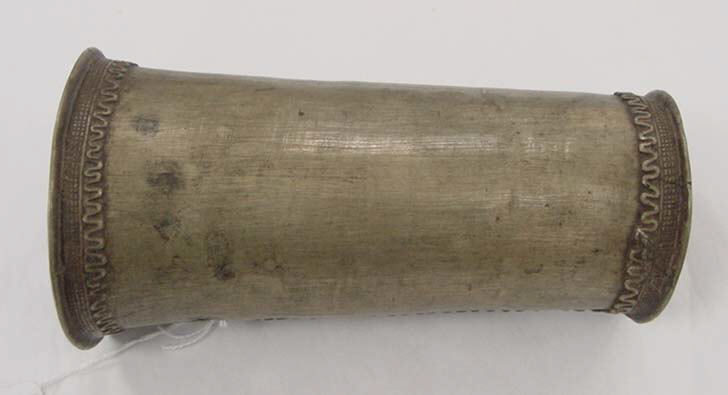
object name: bracelet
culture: african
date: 1801-1900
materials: metal